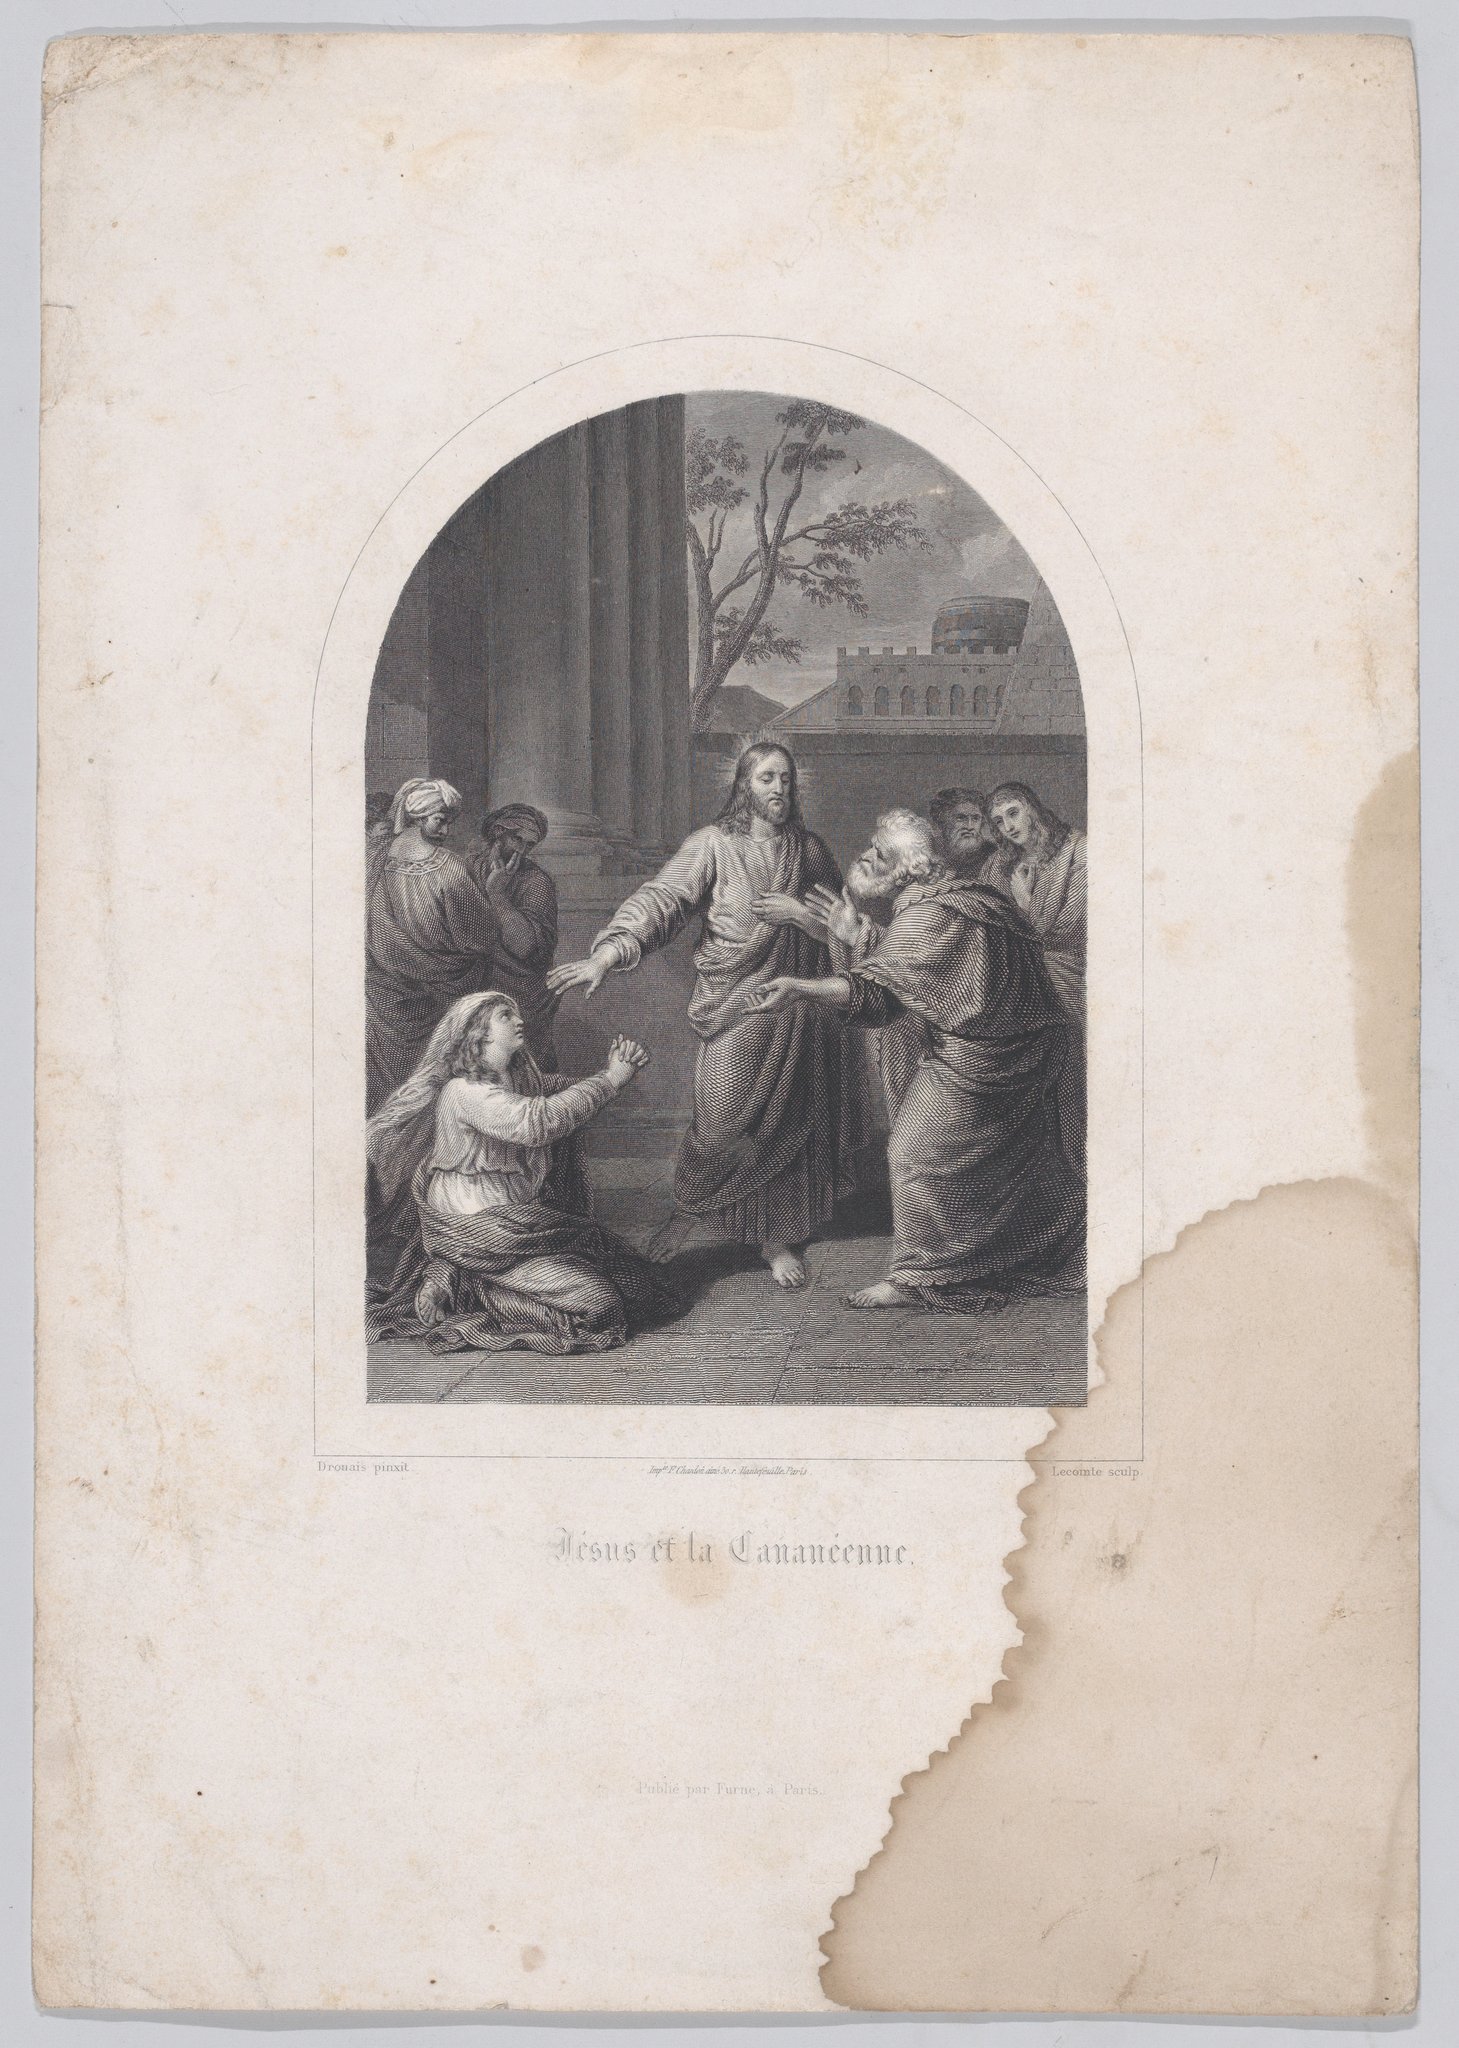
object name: print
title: Jesus et la Cananéenne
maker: hipolyte lecomte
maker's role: artist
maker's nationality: french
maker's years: 1781-1857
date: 1820-1857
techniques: engraving